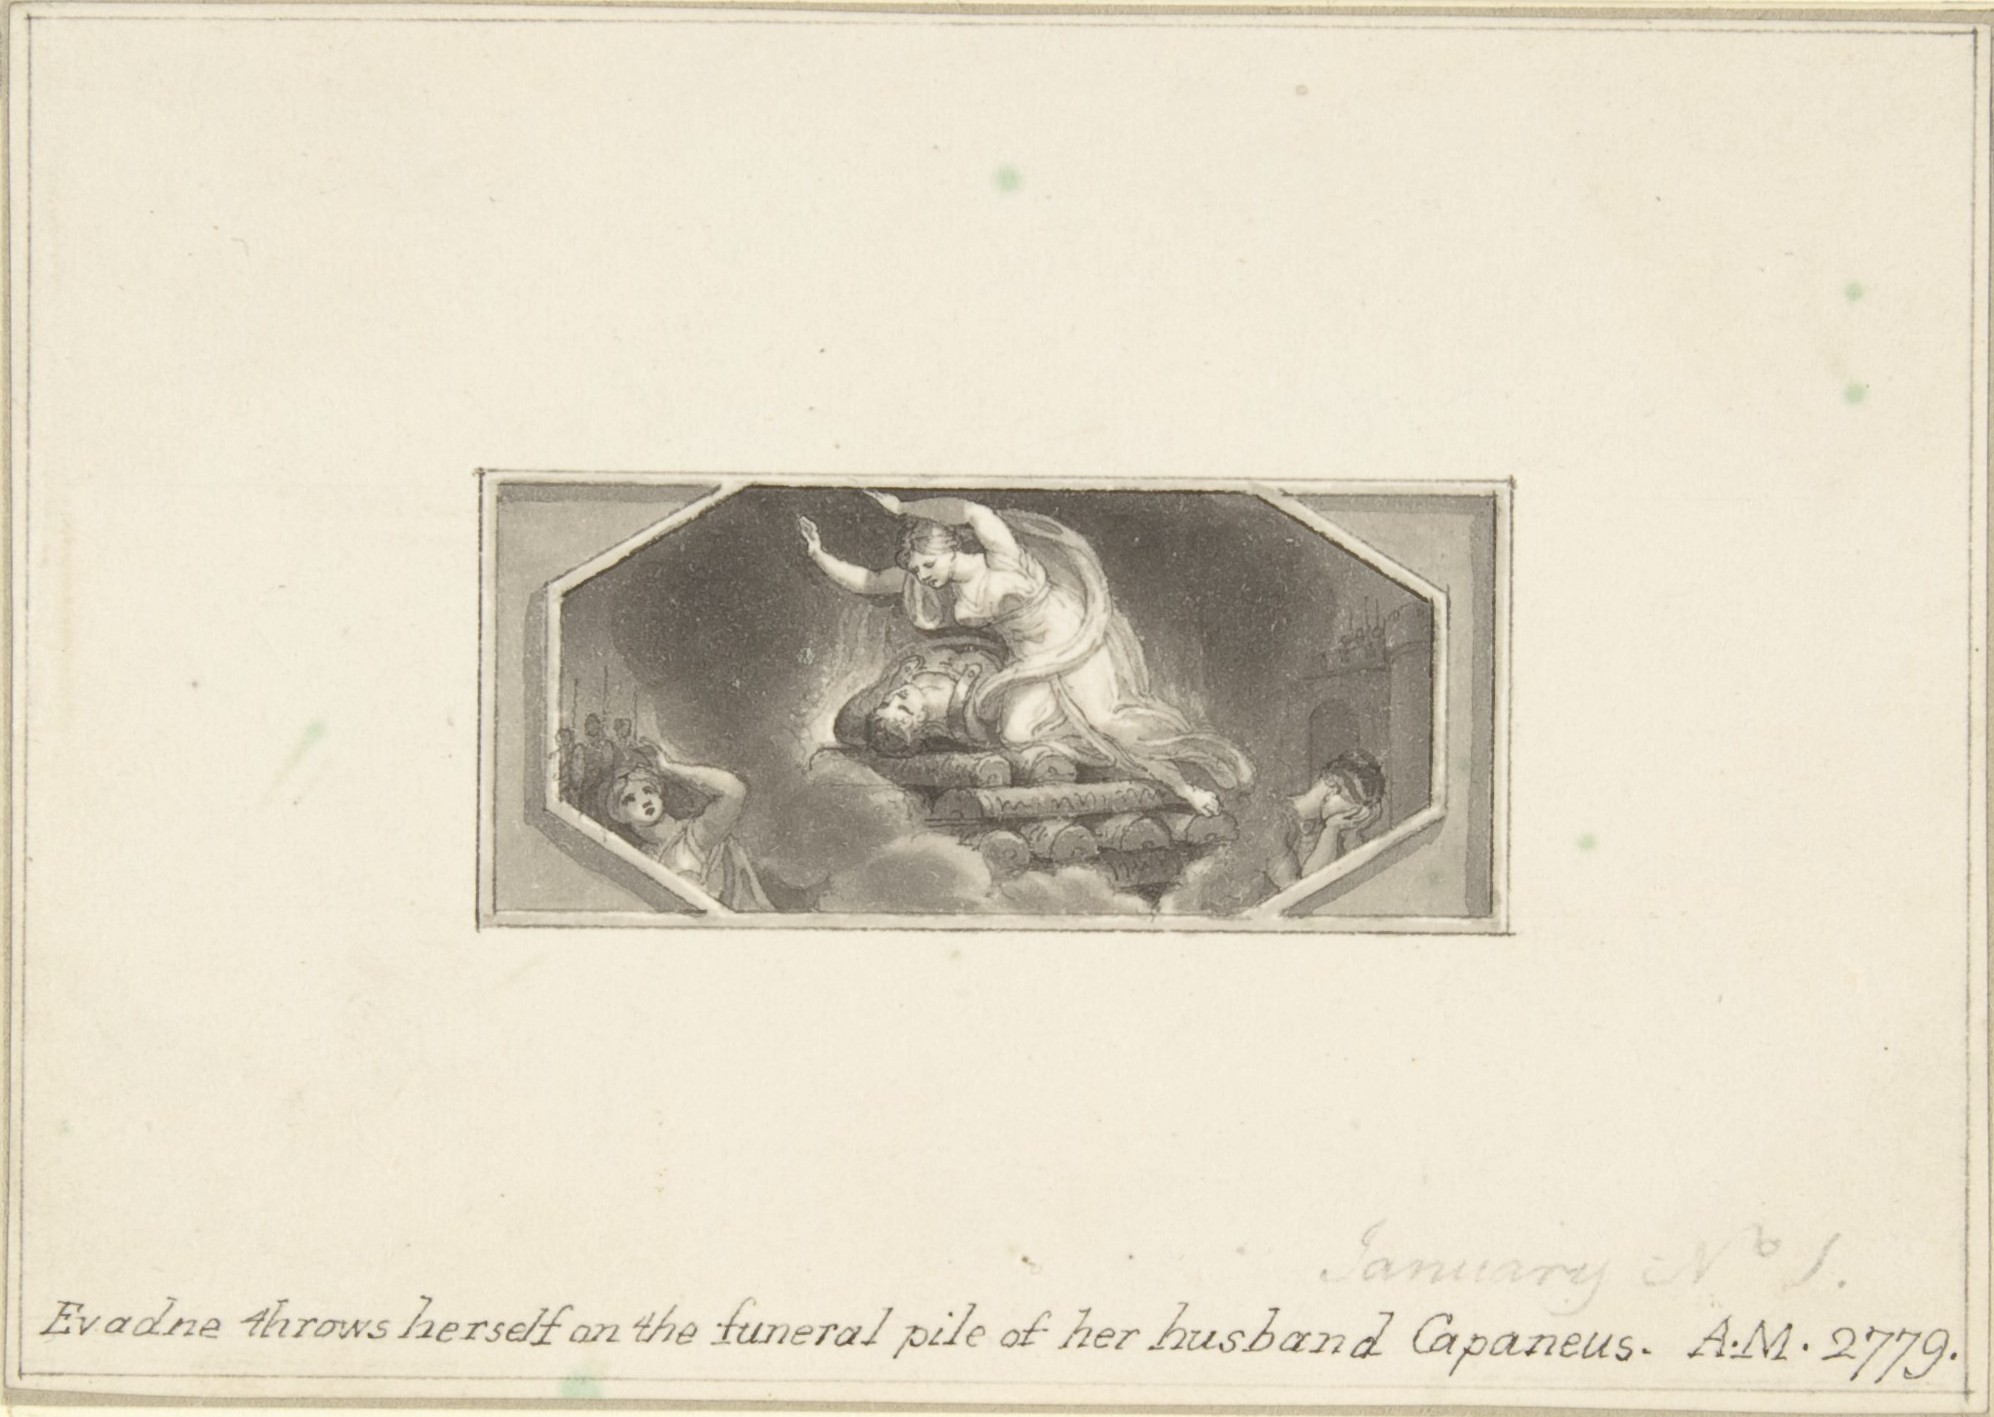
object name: drawing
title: Evadne throws herself on the Funeral Pile of her Husband Capaneus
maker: edward francis burney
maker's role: artist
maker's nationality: british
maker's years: 1760-1848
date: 1790-1800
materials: ink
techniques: brush, pen, wash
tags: men,women,death